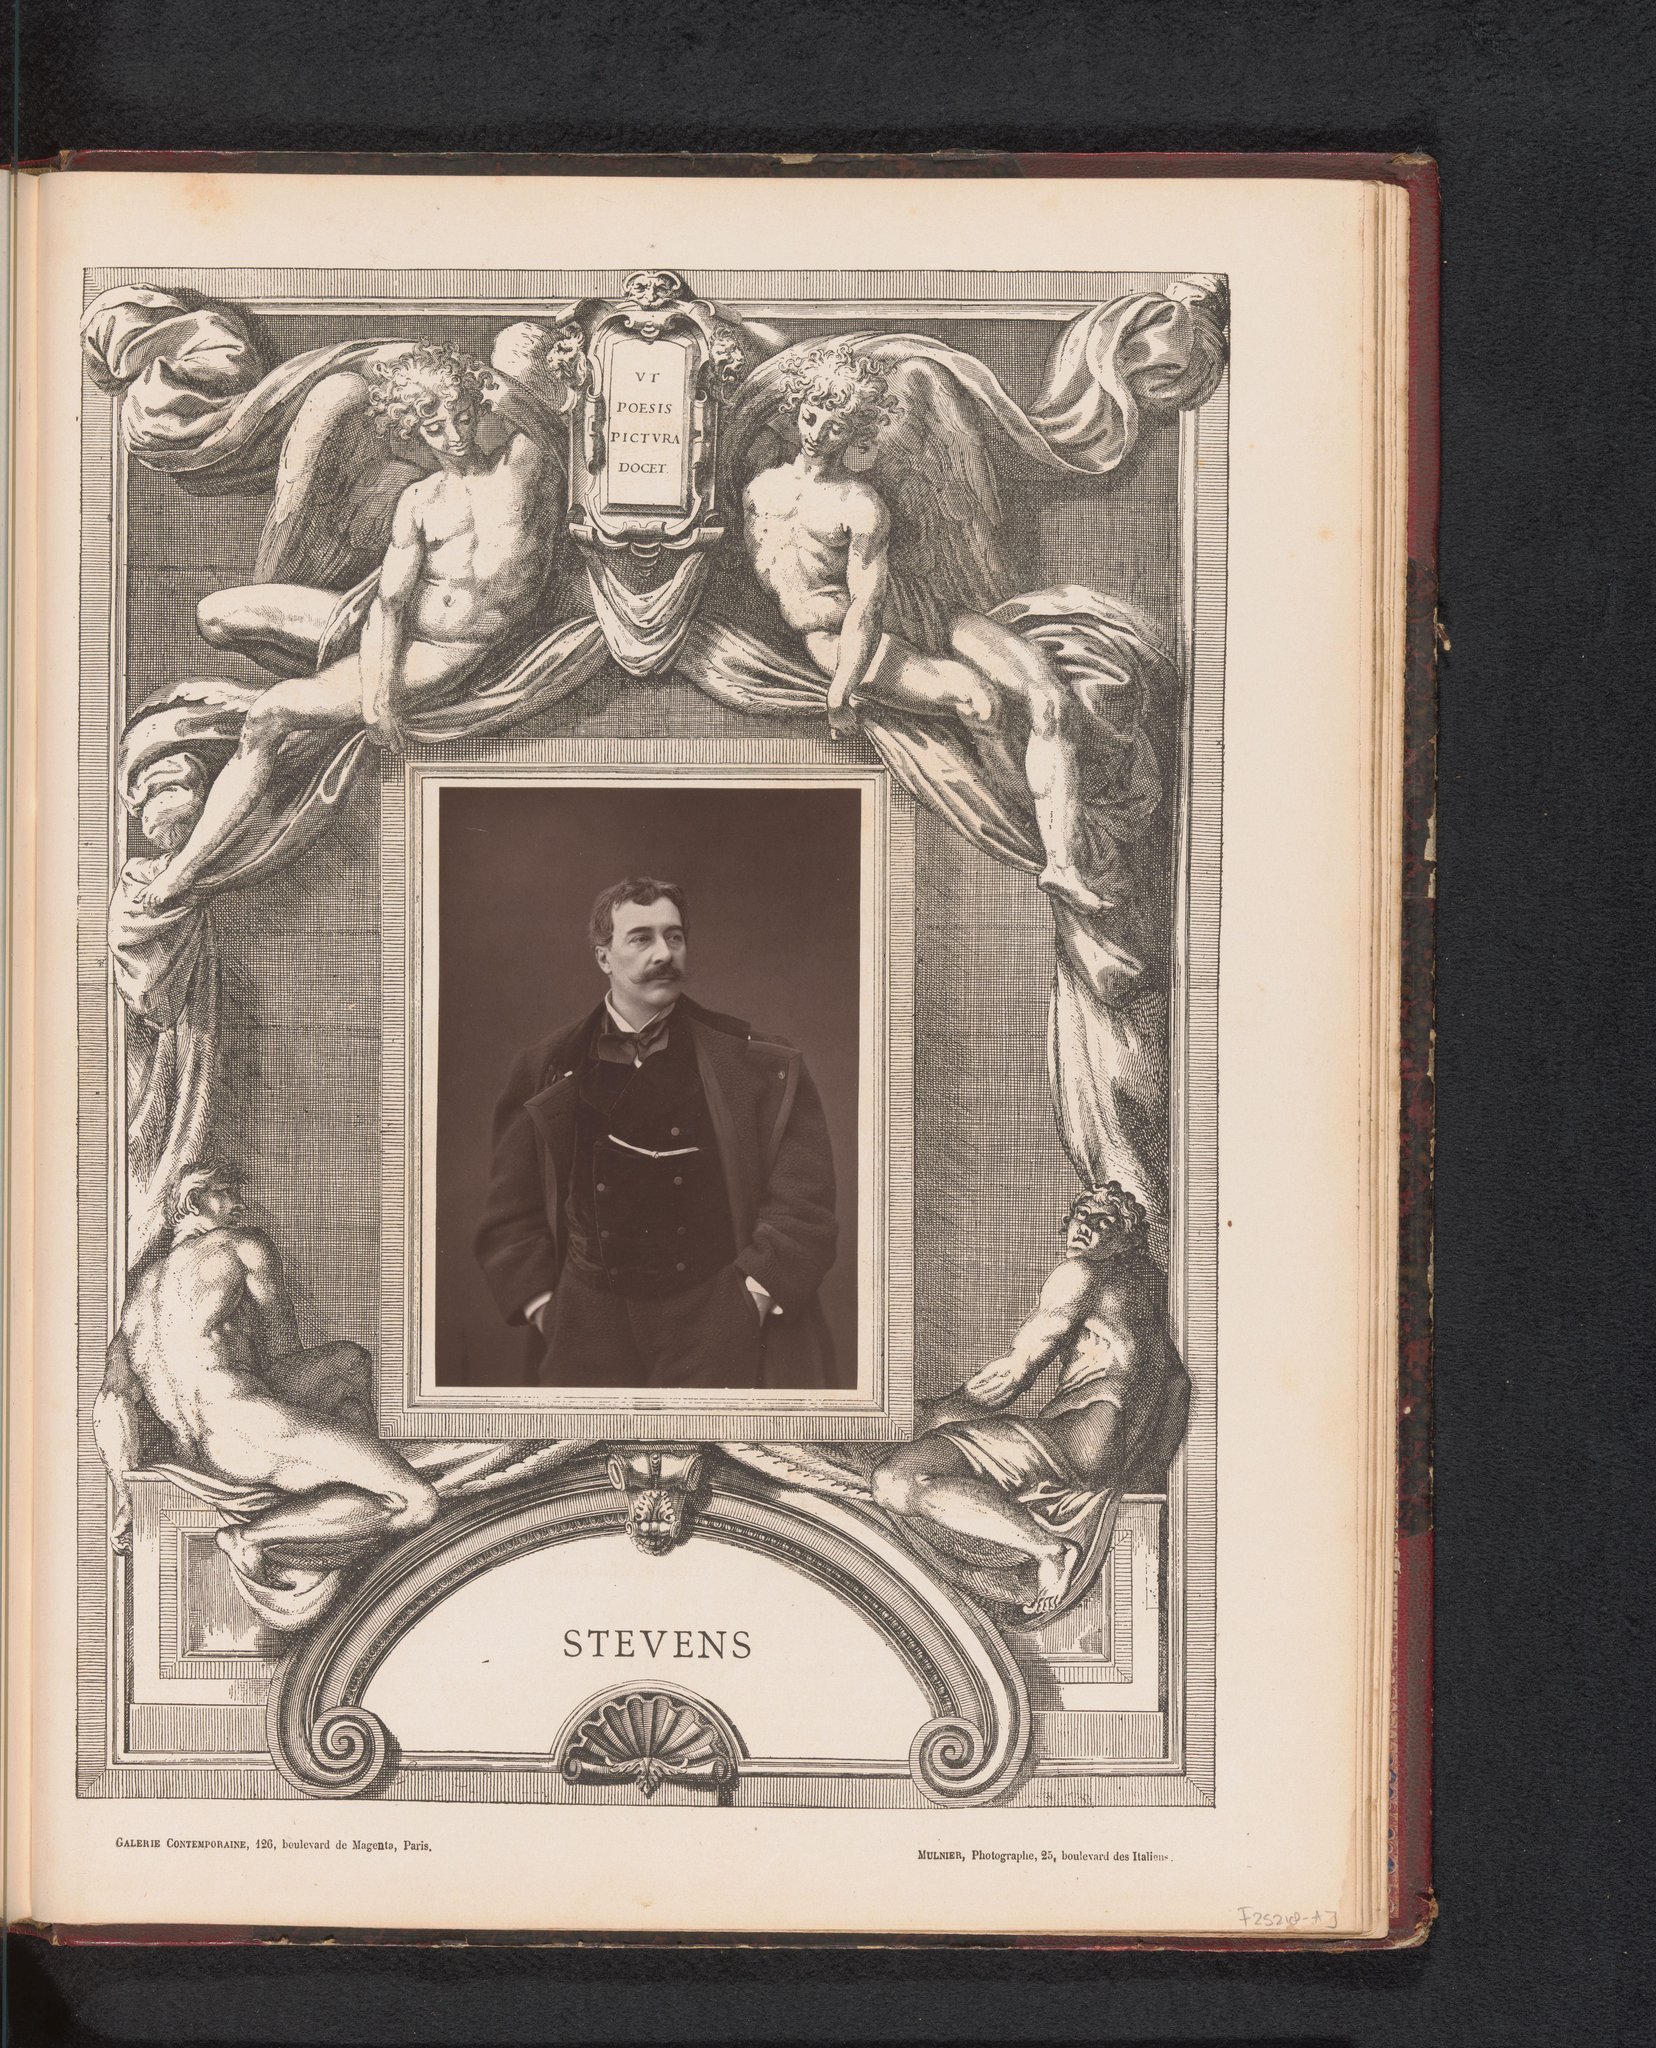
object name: page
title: Stevens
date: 1872-1877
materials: paper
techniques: woodburytype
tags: brussels, painter, print maker, alfred stevens, adult man, historical persons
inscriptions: inscription: ‘Galerie Contemporaine, 126, boulevard de Magenta.’